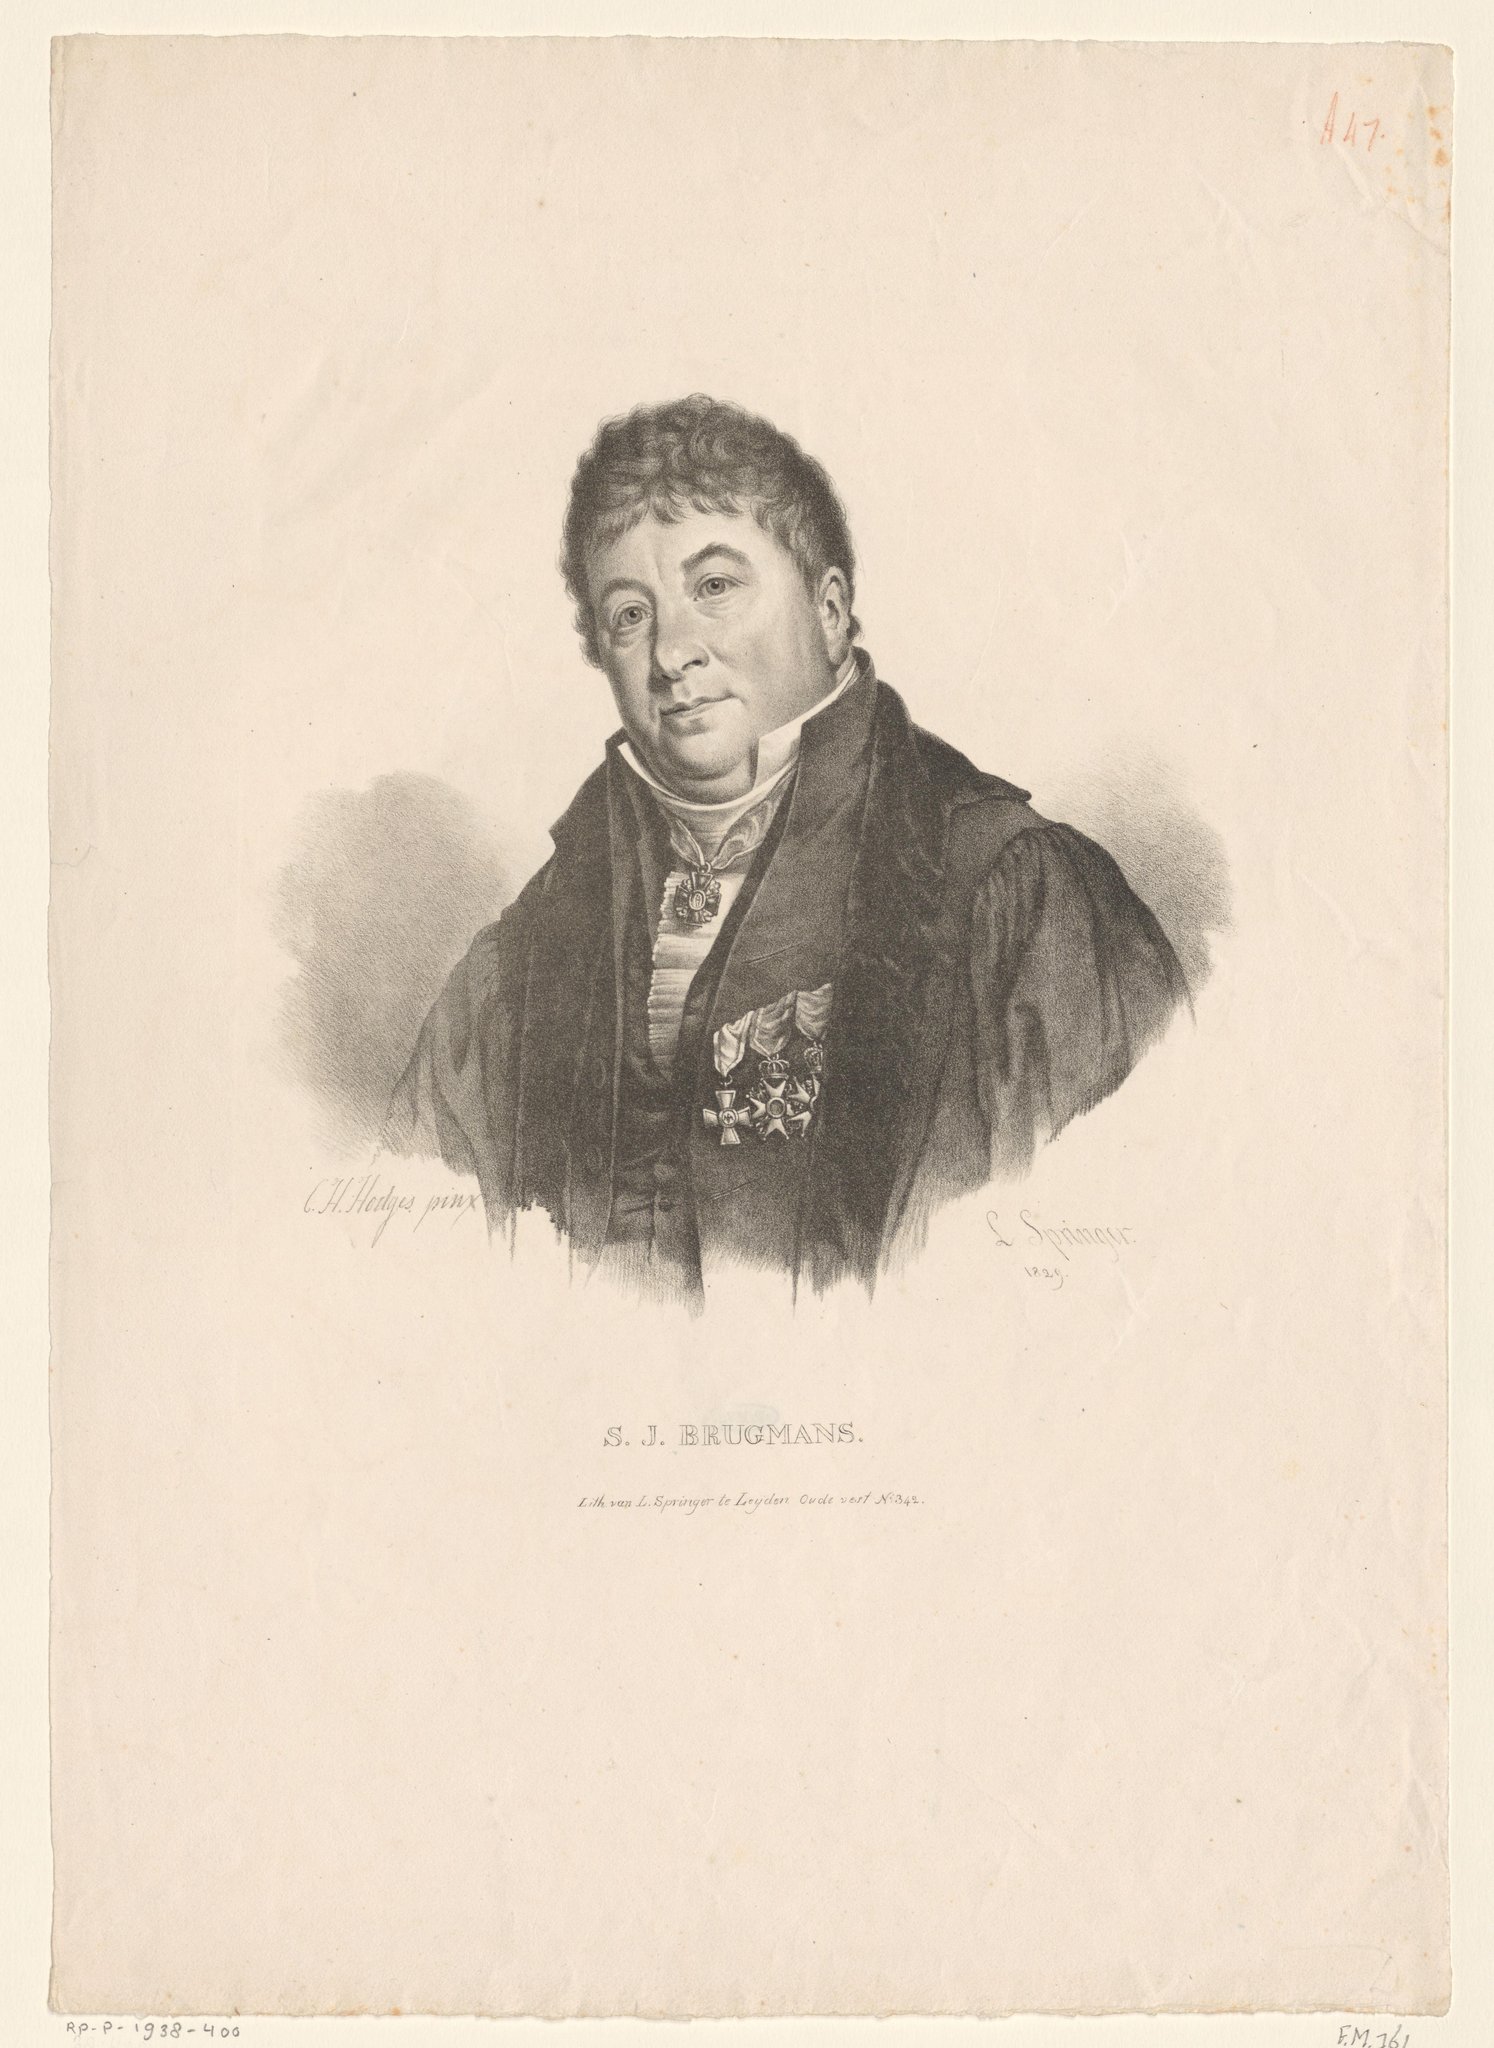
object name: print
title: Portret van Sebald Justinus Brugmans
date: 1829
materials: paper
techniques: lithograph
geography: leiden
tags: leiden, scholar, philosopher, historical persons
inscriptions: inscription: ‘A47’, collector's mark: Lugt 2228